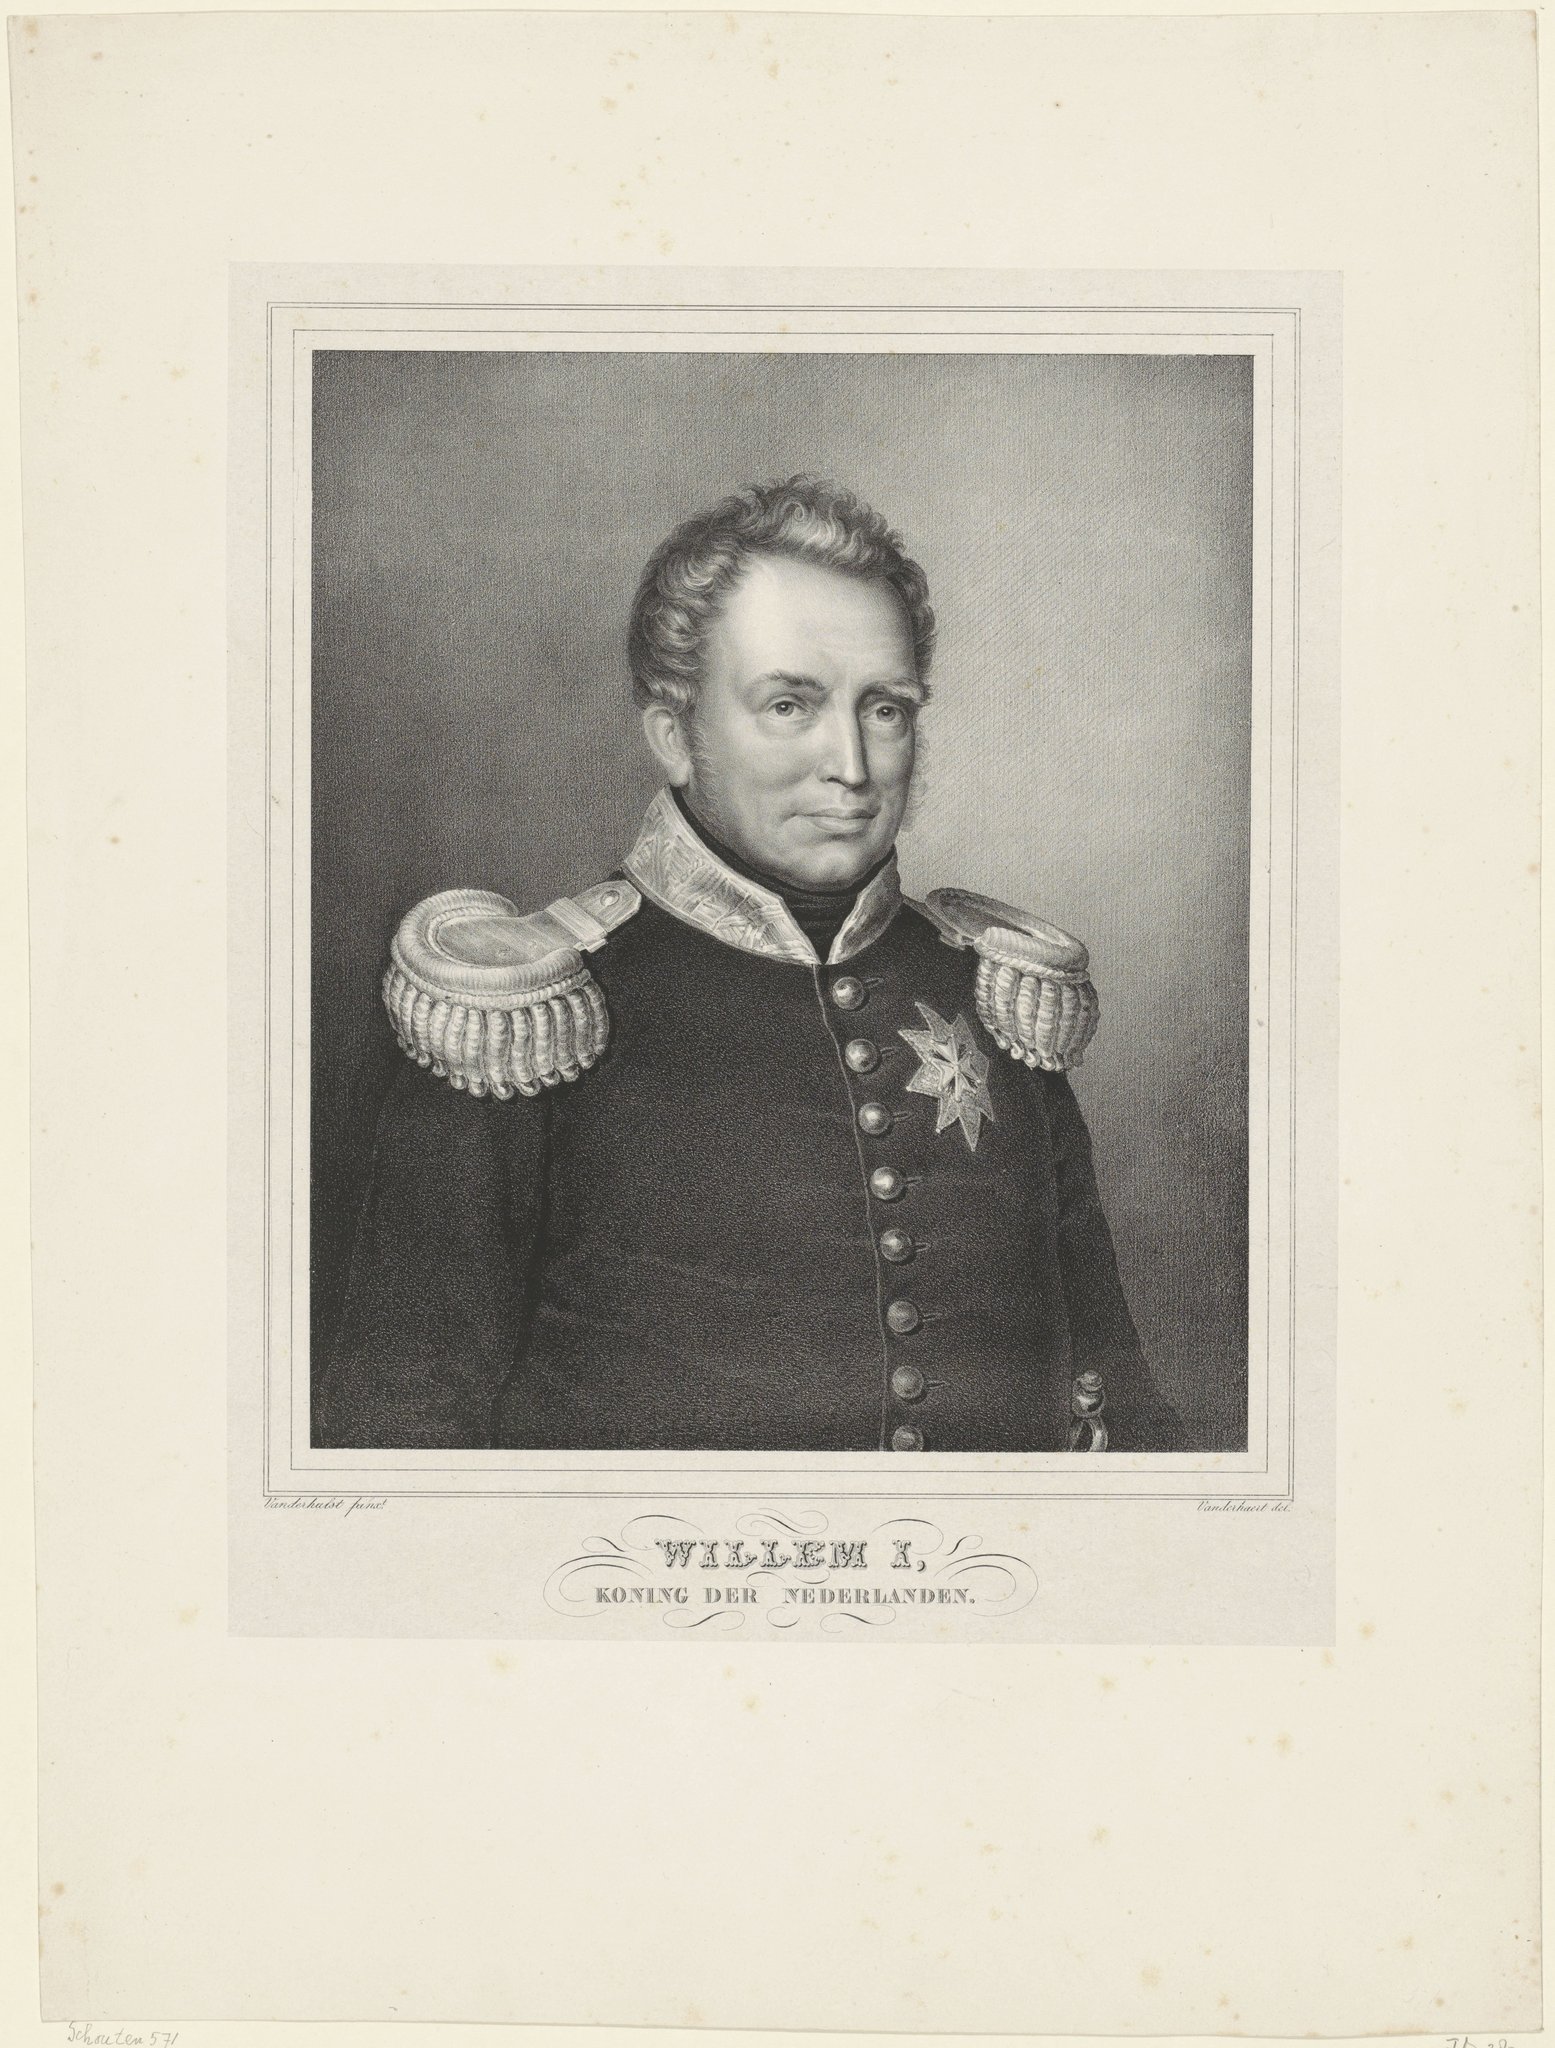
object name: print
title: Portret van Willem I Frederik, koning der Nederlanden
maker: jean-baptiste van der hulst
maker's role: draughtsman, painter, print maker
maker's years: 1790-1862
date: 1815-1846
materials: paper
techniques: lithograph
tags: the hague, william i of the netherlands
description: De hier vermelde titel verwijst naar de hoogst verkregen titel van de geportretteerde, niet per se naar de titel die de geportretteerde op deze voorstelling draagt.